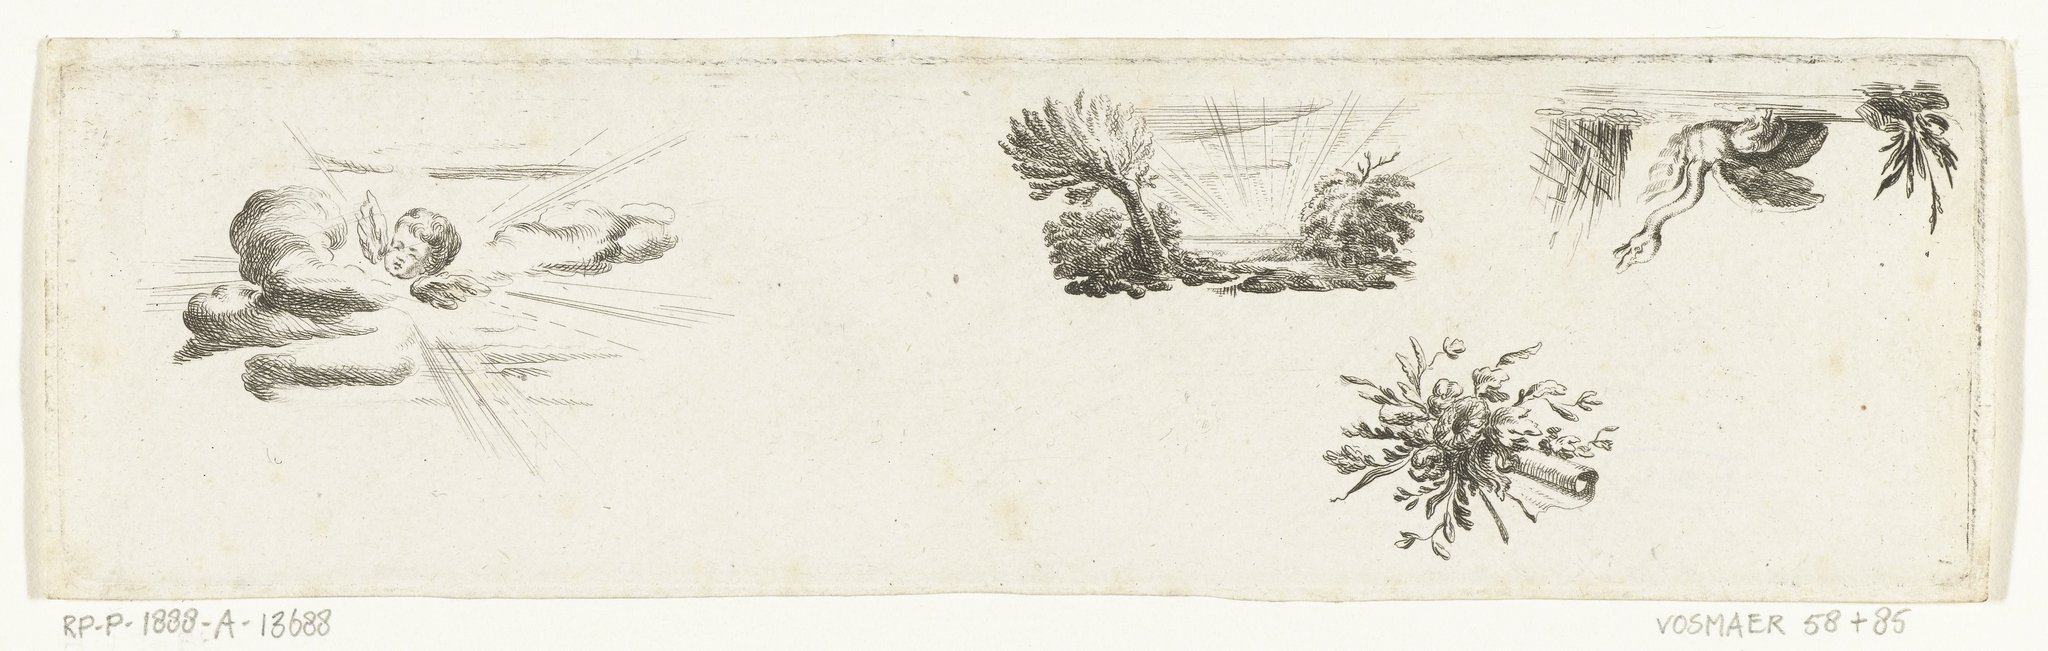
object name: vignette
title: Blad met vier vignetten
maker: willem bilderdijk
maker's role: draughtsman, print maker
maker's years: 1756-1831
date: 1766-1785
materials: paper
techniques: etching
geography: netherlands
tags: cherubs, i.e. children's heads with wings, water-birds: swan, sunrise, vignette, flowers ~ ornament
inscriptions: collector's mark: Lugt 2228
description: Blad met vier vignetten: cherubijn voor stralen van de zon in wolken, landschap met opkomende zon, water met opvliegende zwaan en schriftrol met bloemen.